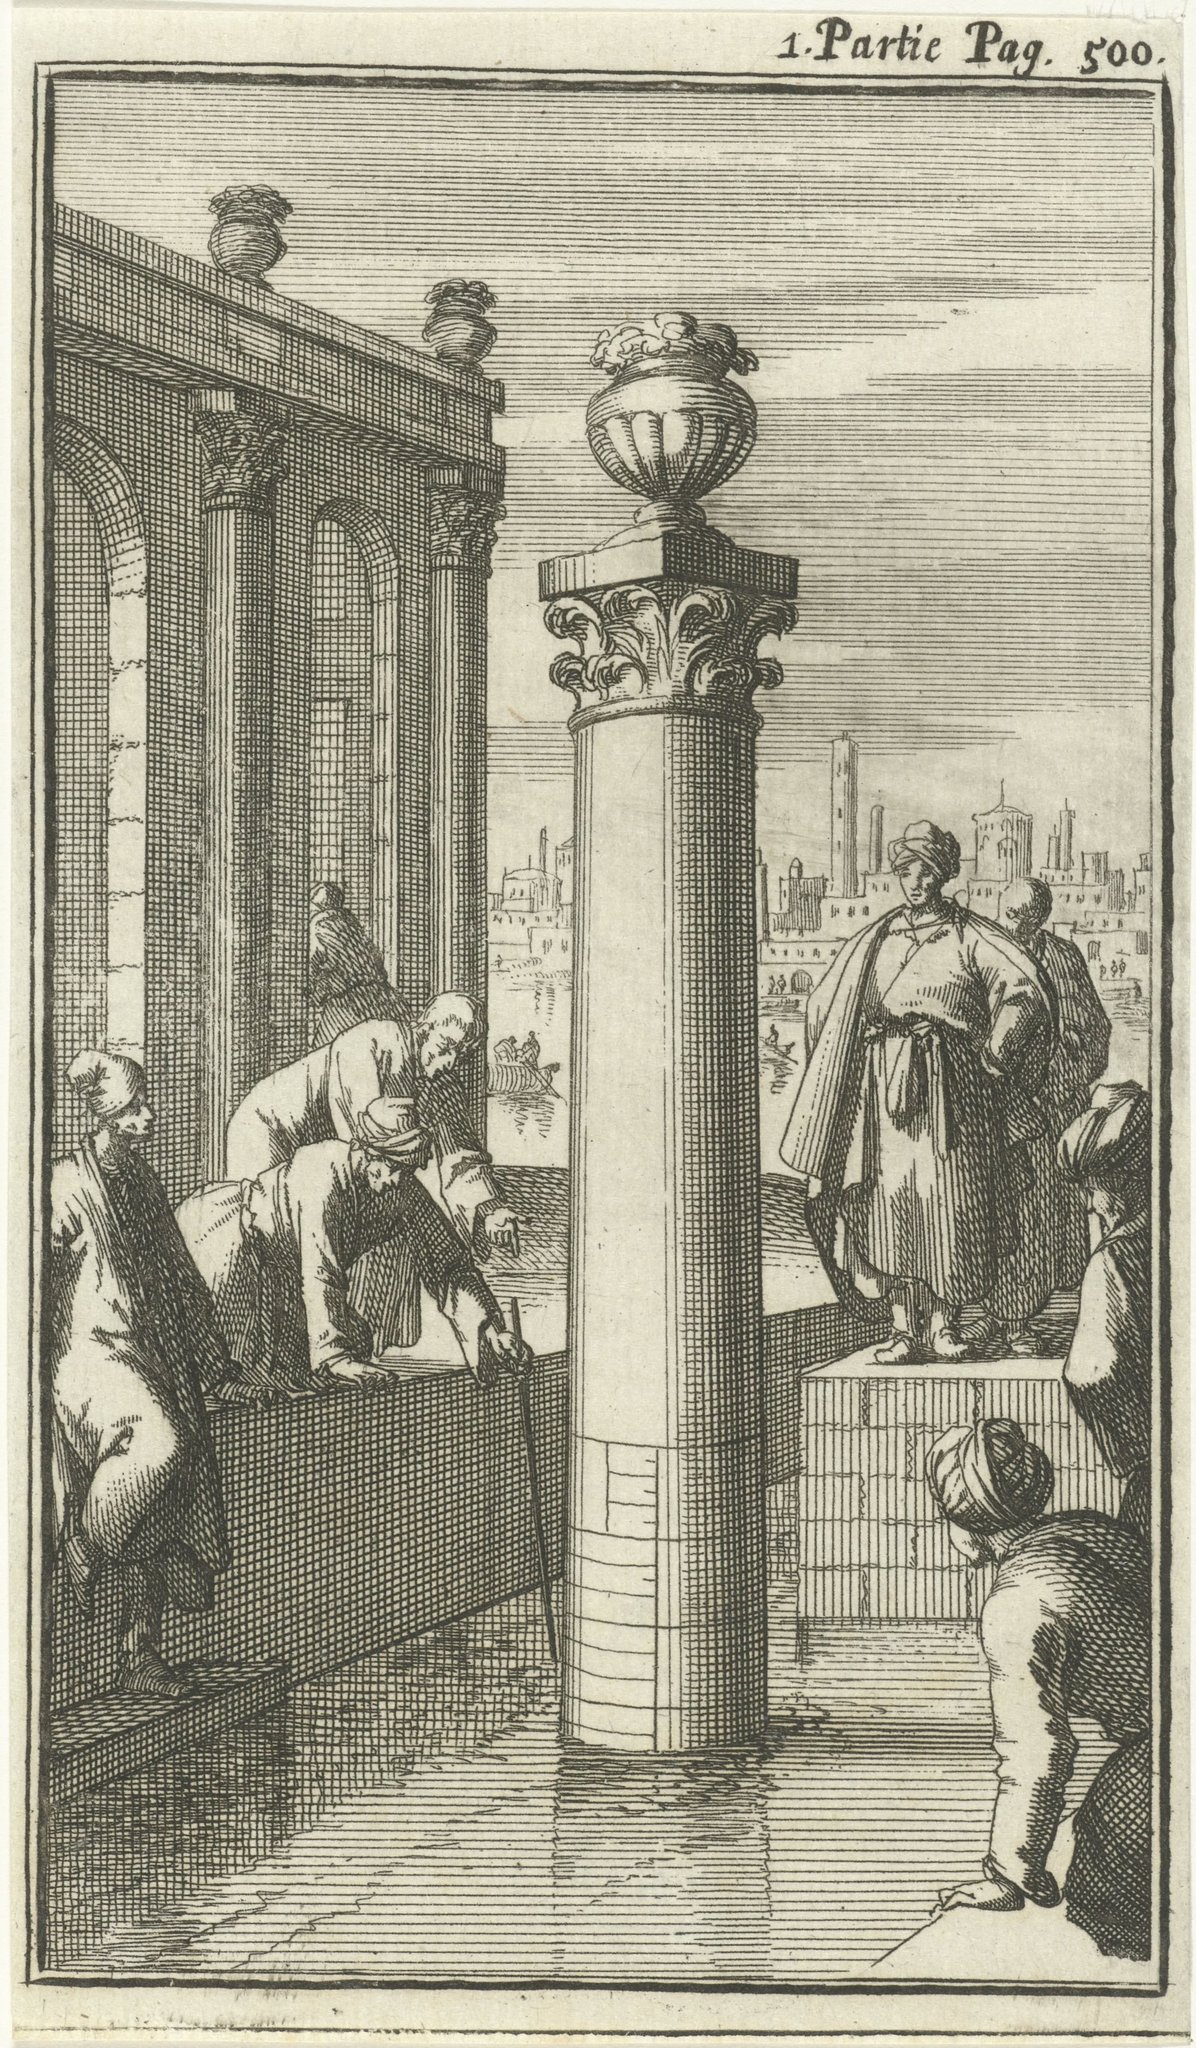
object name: book illustration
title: Onderzoek naar de waterstand bij de Nijlmeter te Caïro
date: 1689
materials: paper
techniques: etching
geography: paris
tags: river, measuring-instruments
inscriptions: collector's mark: Lugt 2228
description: Illustratie uit: Thevenot, Jean de. Voyages Tant en Europe qu'en Asie et en Afrique, 4 delen. Parijs: Charles Angot, 1689, dl. II.